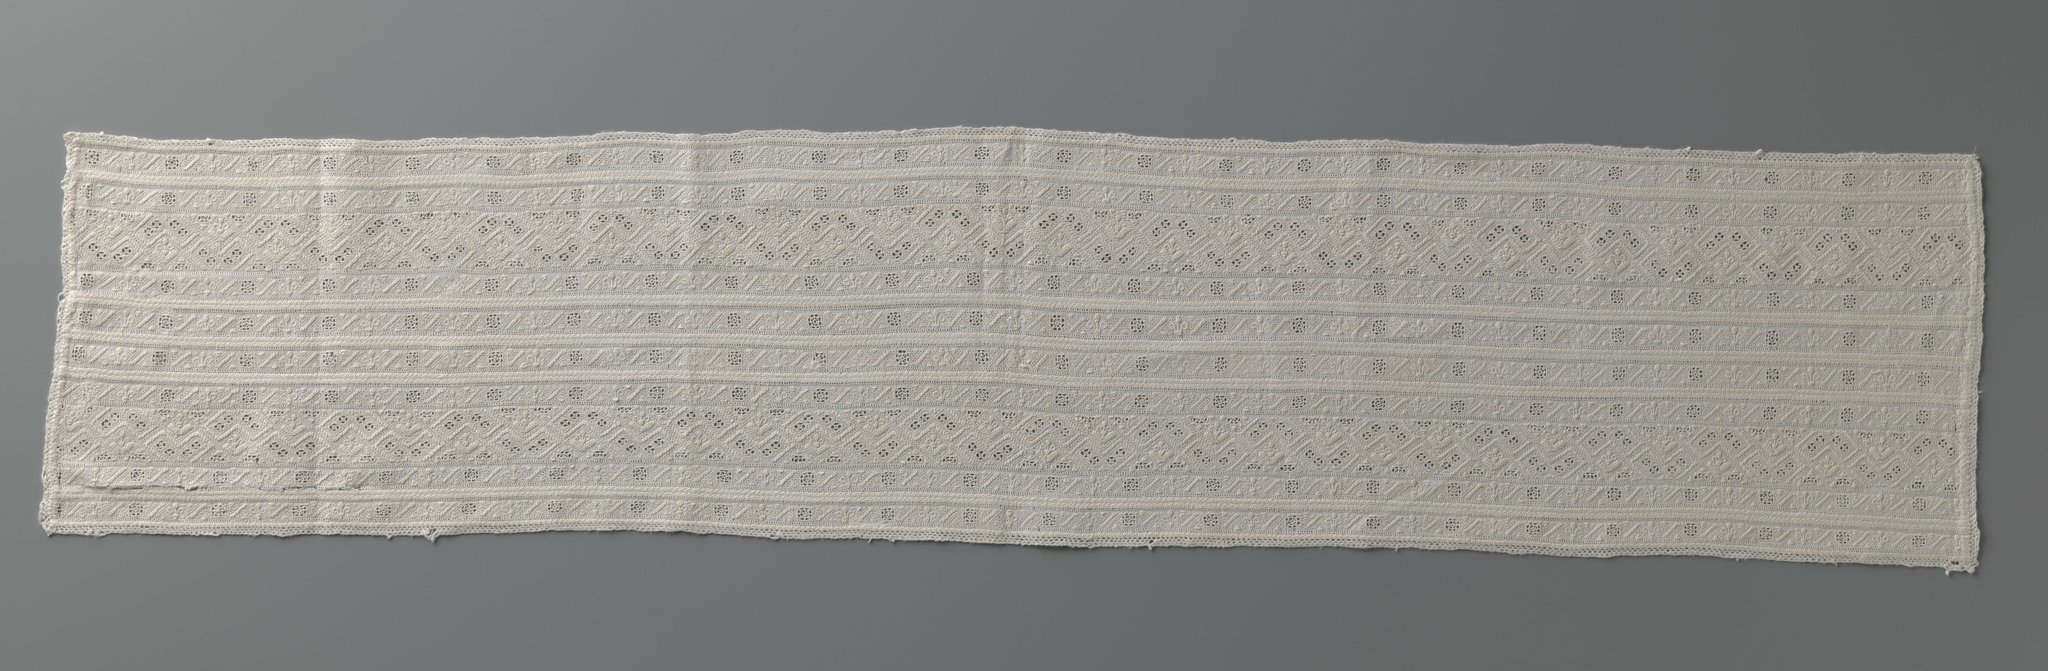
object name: strip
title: Strook geborduurd linnen met open naaldkantsteken afkomstig van een beddenlaken en samengesteld uit verschillende stroken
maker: Anonymous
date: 1600-1699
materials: linen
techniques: embroidered, weave, embroidery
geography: northern netherlands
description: Strook naturelkleurig geborduurd linnen met open naaldkantsteken: witwerk en Engels borduurwerk. De brede strook is samengesteld uit verschillende smallere stroken afkomstig van een 17de-eeuws beddenlaken. De strook is langs alle zijden afgewerkt met een smal gehaakt bandje.